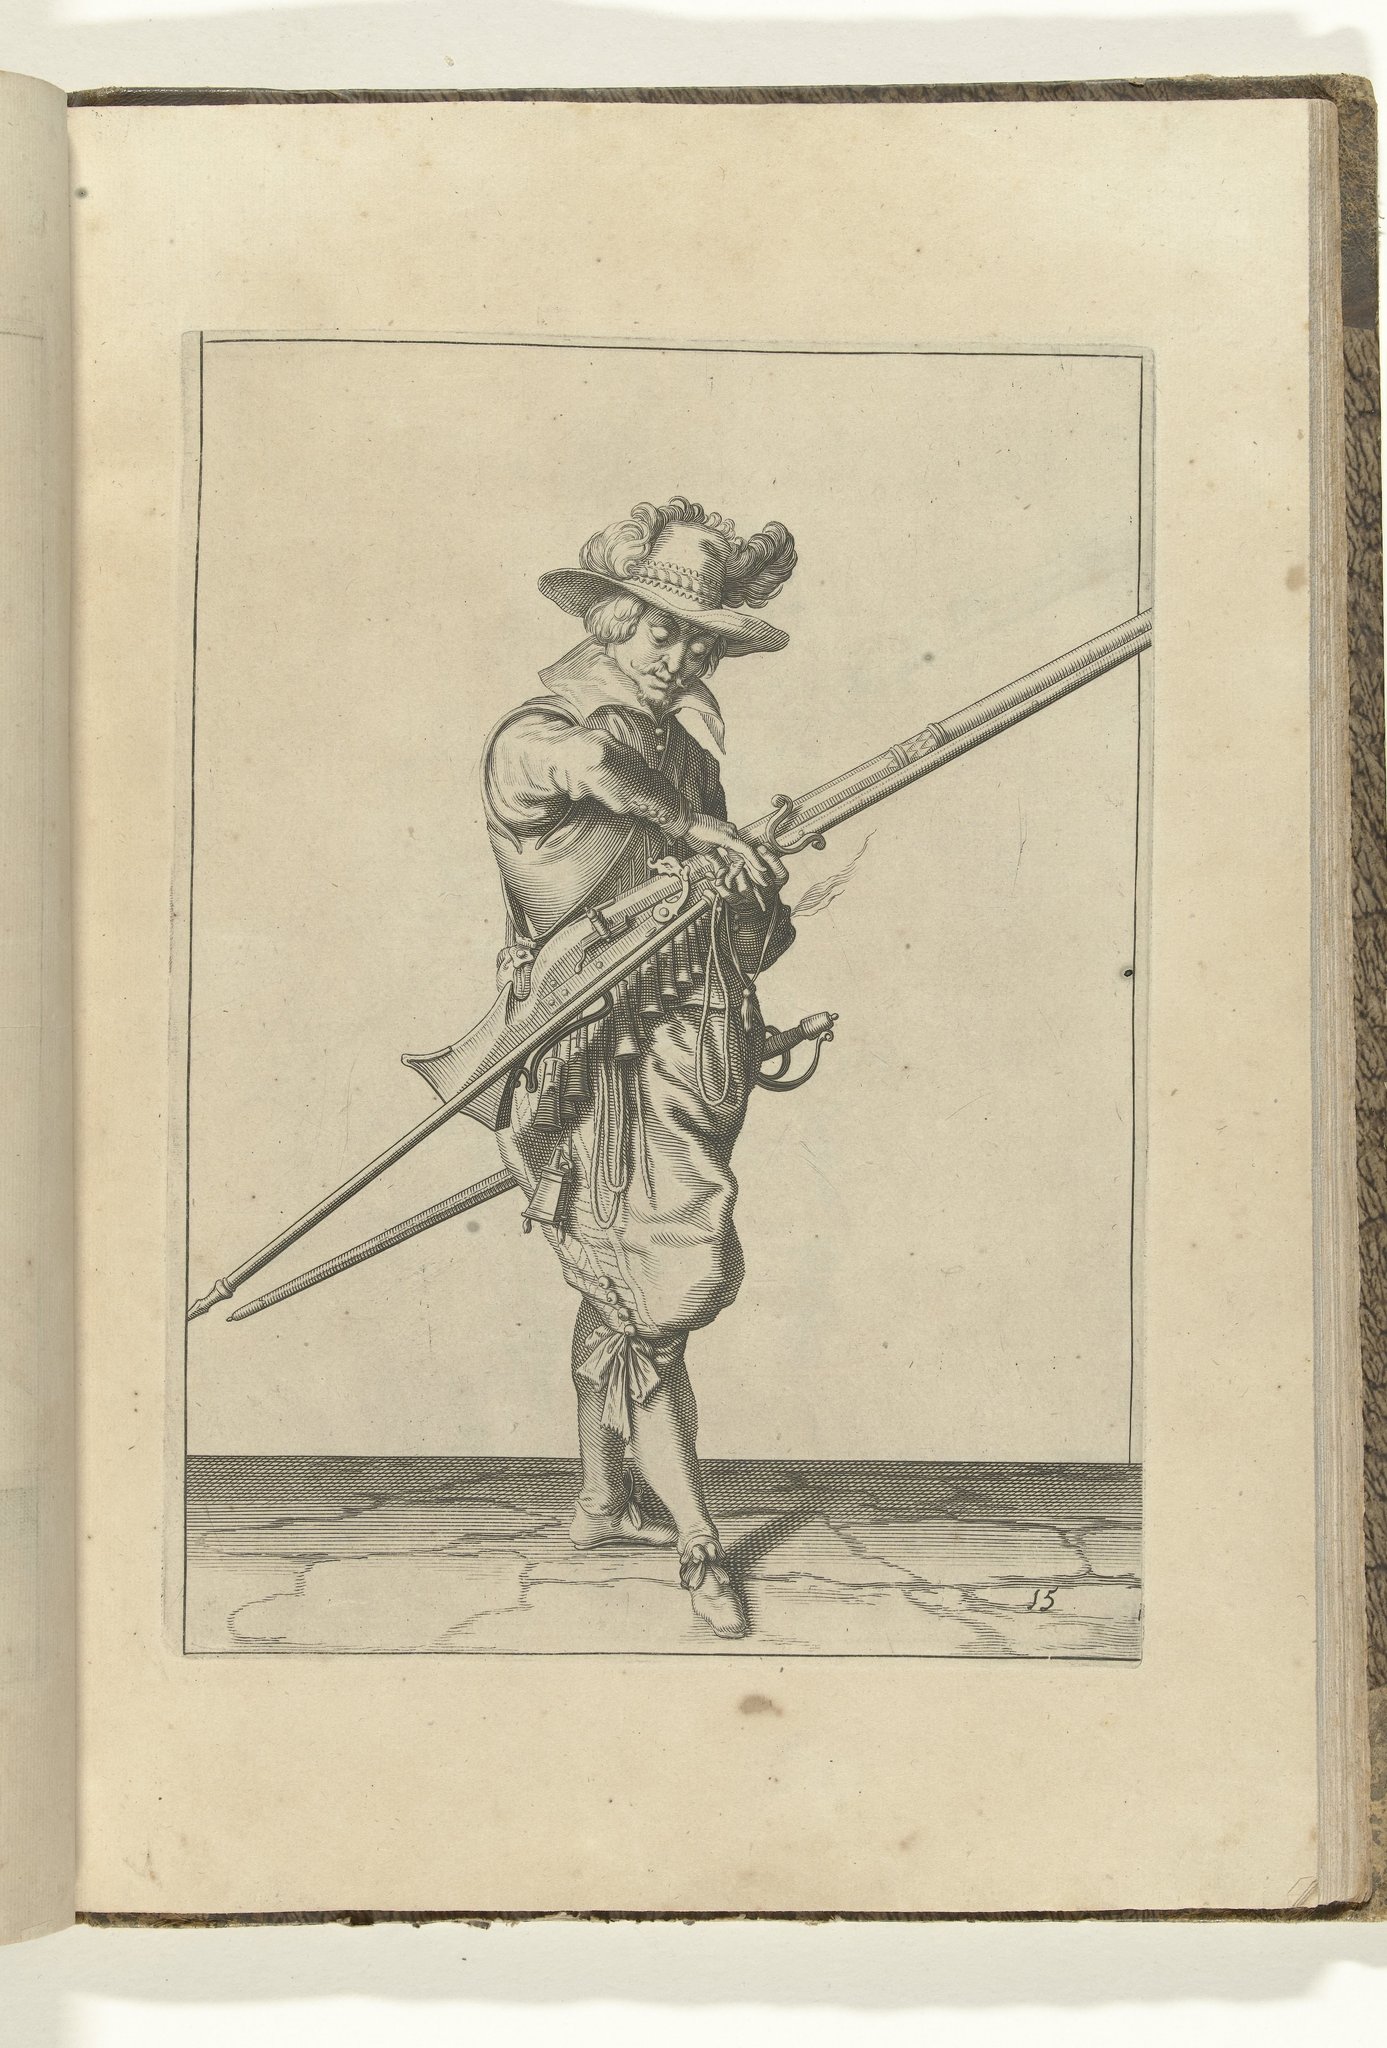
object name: print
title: Soldaat met een musket die zijn lont overbrengt van zijn rechter- naar zijn linkerhand (nr. 15), ca. 1600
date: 1597-1608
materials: paper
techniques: engraving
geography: amsterdam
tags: maurice (prince of orange), handling of weapons ~ military training, weapons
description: Een soldaat, ten voeten uit, naar rechts, die een musket (een bepaald type vuurwapen) en een furket (musketvork) met zijn linkerhand vasthoudt (nr. 15), ca. 1600. De brandende lont in zijn rechterhand brengt hij over naar zijn linkerhand. Plaat 15 in de instructies voor het hanteren van het musket: Brief enseignement, sur les pourtraitz figurez, touchant le droit maniement du Mousquet. Onderdeel van de illustraties in een Franse editie van J. de Gheyns Wapenhandelinghe: J. de Gheyn, Maniement d'armes, d'arquebuses, mousquetz et piques : en conformité de l'ordre de Mour le Prince Maurice, Prince d'Orange, Amsterdam 1608. Krijgswezen rond 1600.